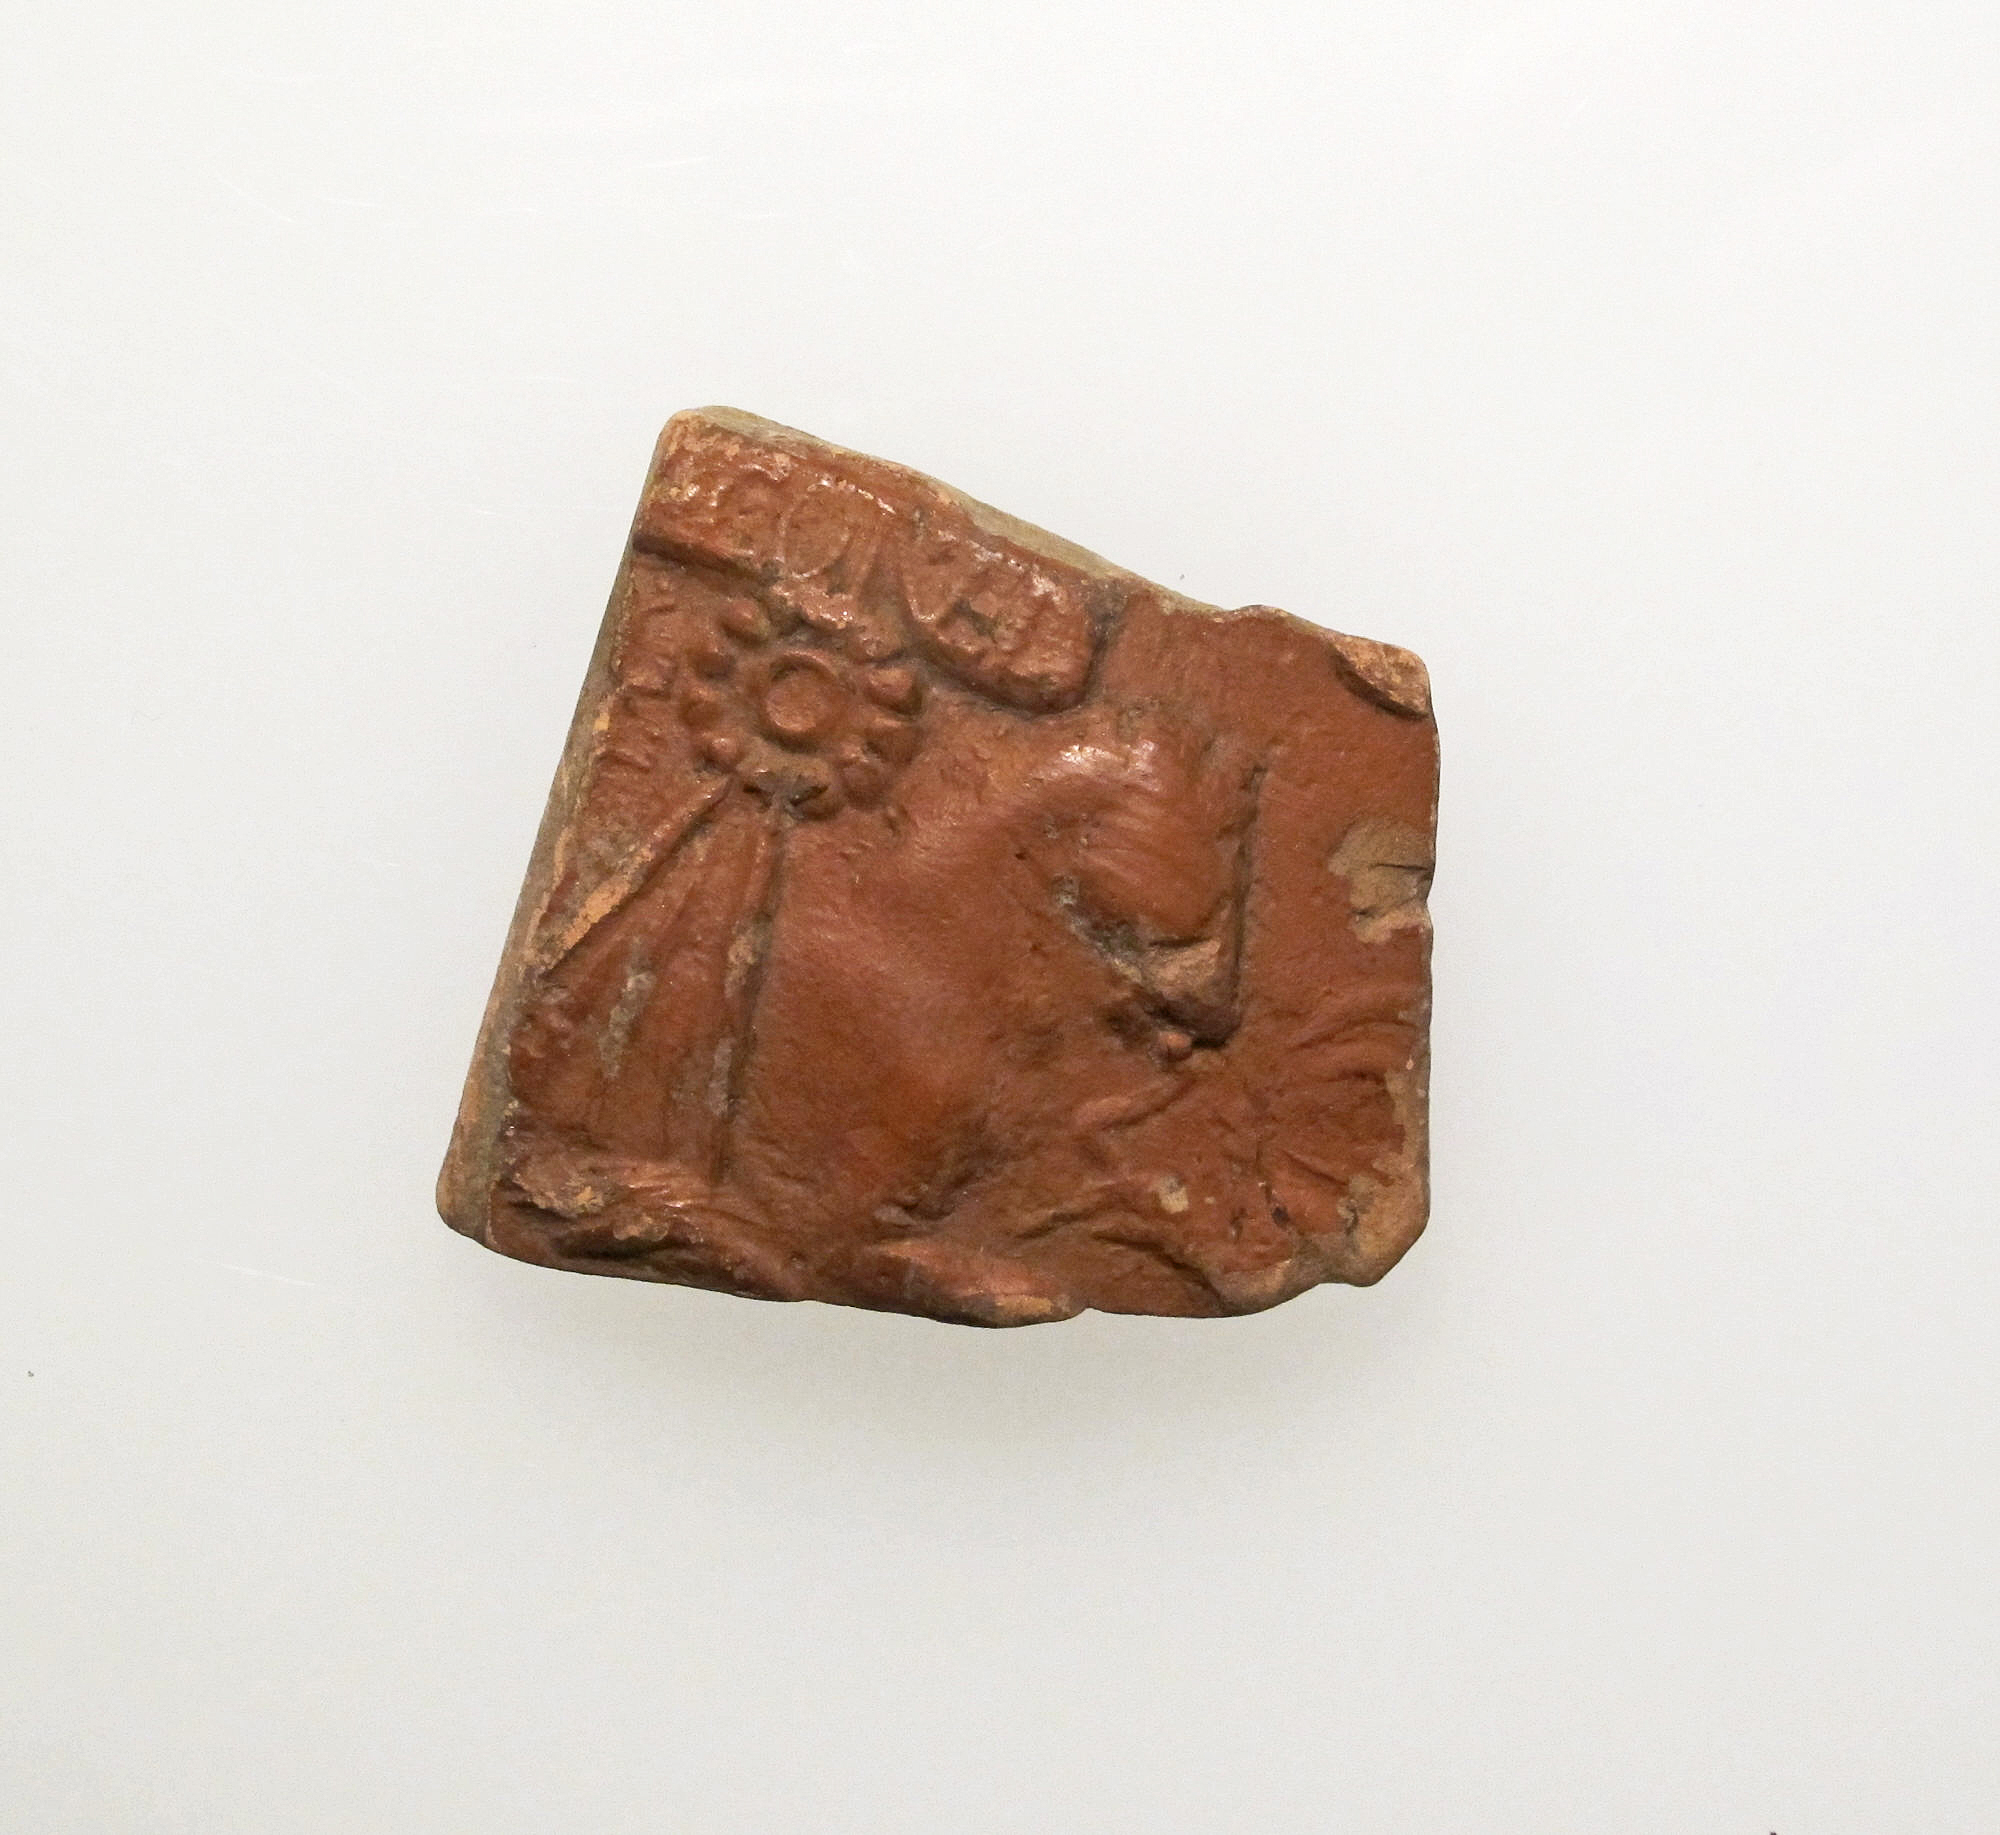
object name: vase fragment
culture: roman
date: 100 BCE-100 CE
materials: terracotta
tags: horses